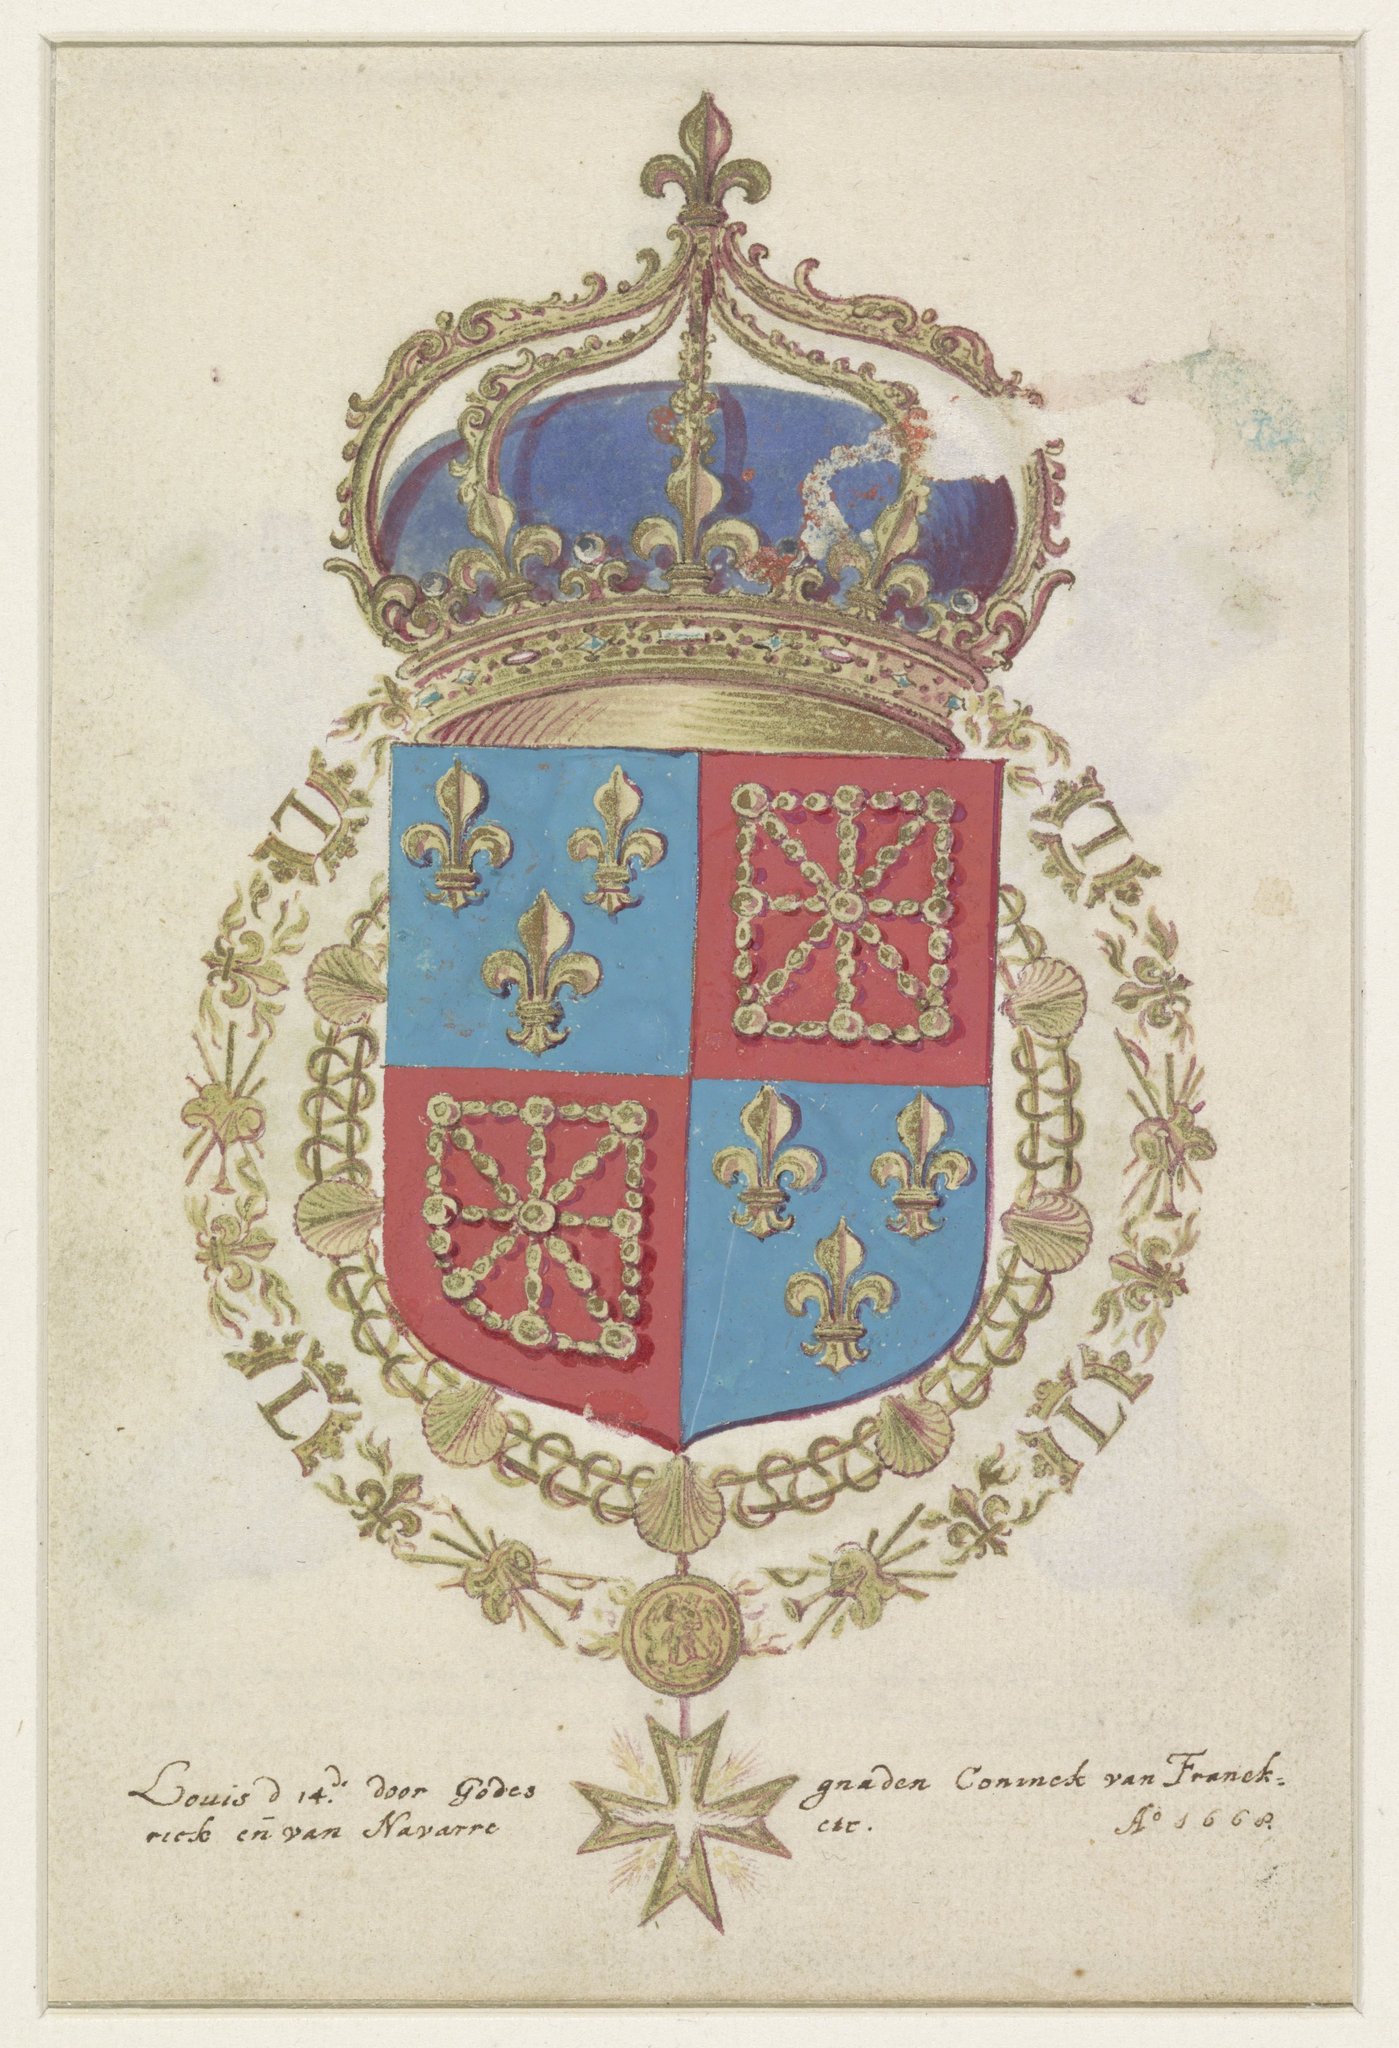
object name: drawing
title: Wapen van Lodewijk XIV, koning van Frankrijk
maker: Anonymous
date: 1668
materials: paint, paper, watercolor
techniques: brush, pen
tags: lodewijk xiv (koning van frankrijk), armorial bearing, heraldry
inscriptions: inscription: ‘Louis d 14de door Godes gnaden Coninck van Franck-/riek en[de] van Navarre [...] A[nn]o 1668.’